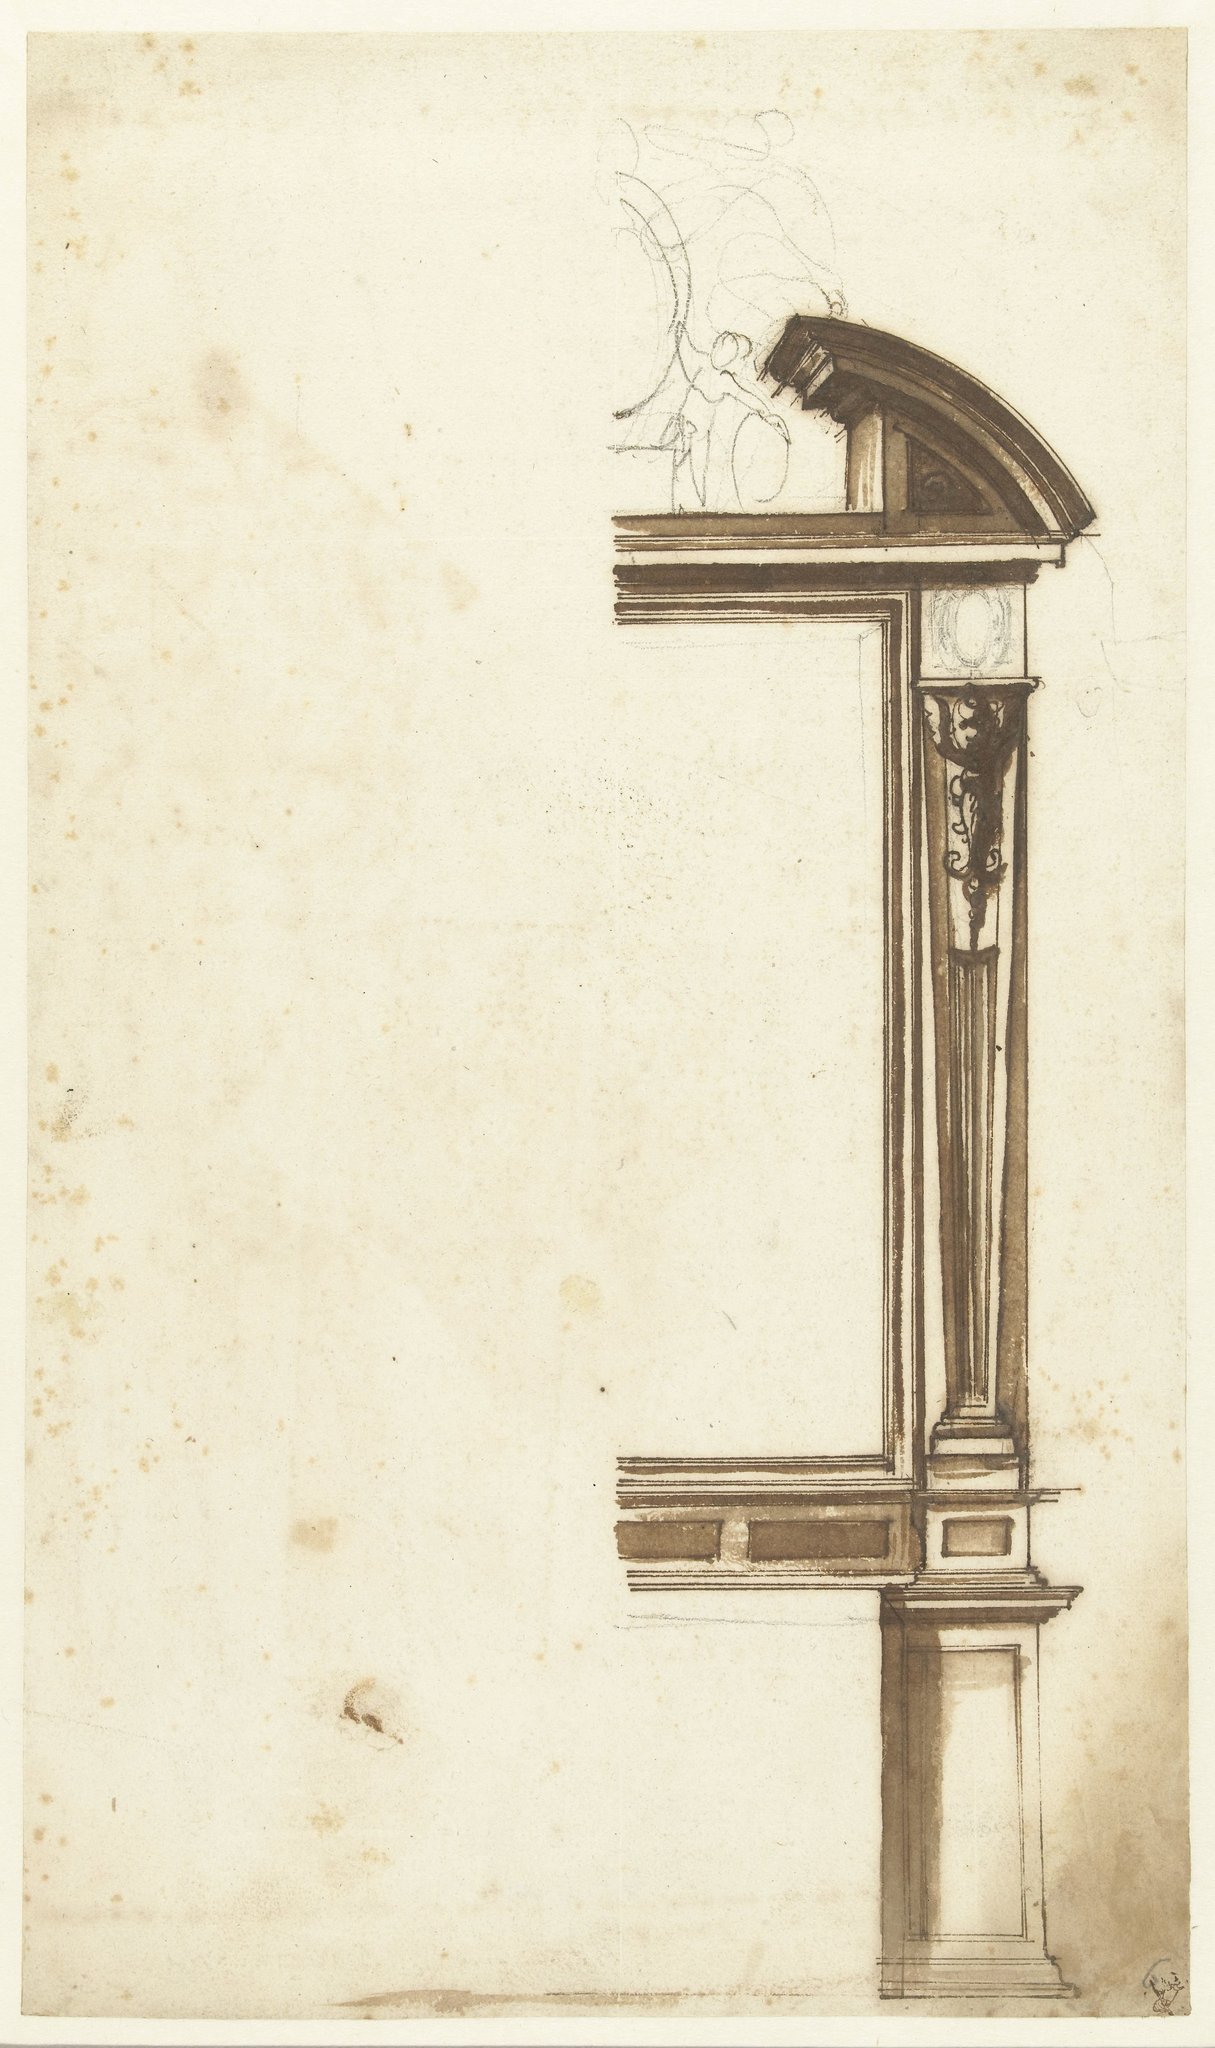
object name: drawing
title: Ontwerp voor de decoratie van een altaar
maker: Anonymous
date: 1590-1610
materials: chalk, graphite, ink, paper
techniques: brush, pen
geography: italy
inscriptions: inscription: ‘.’